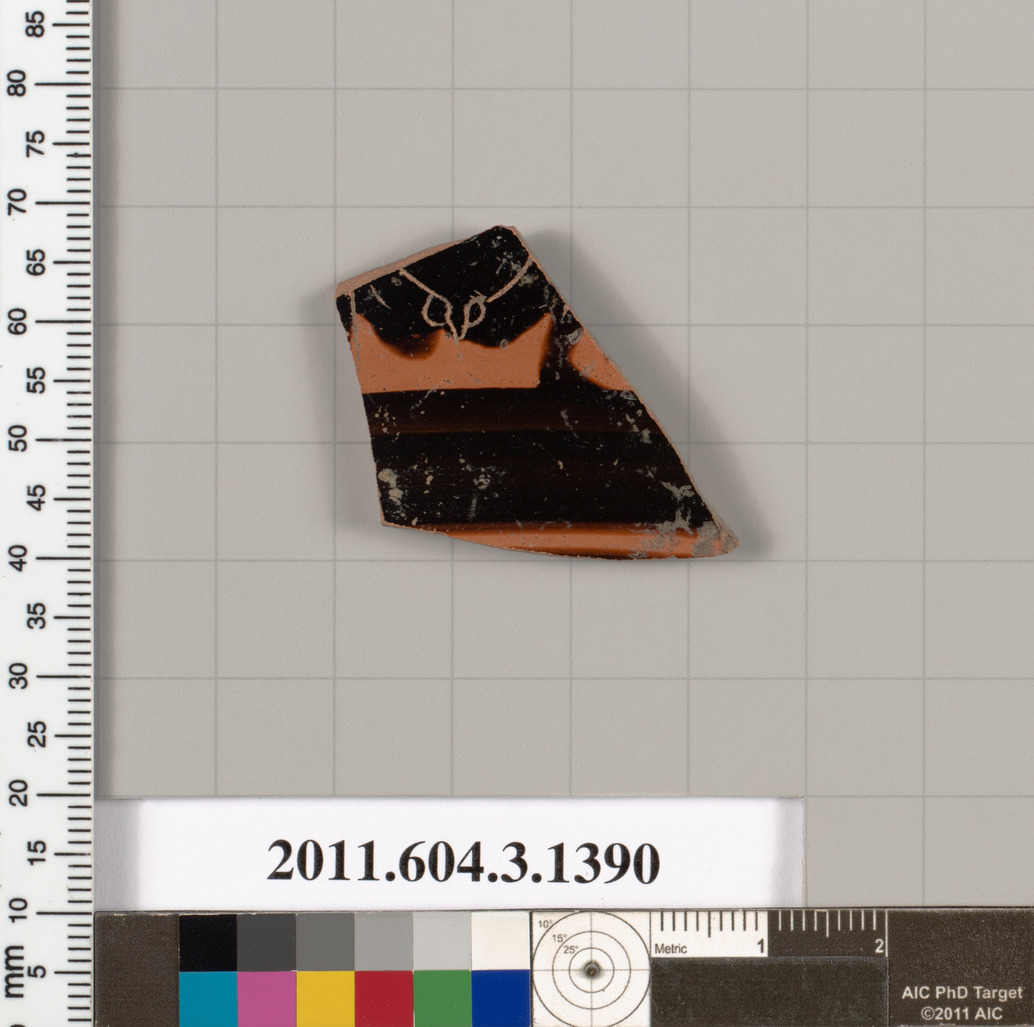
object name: skyphos fragment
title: Terracotta fragment of a skyphos (deep drinking cup)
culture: greek, attic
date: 534-468 BCE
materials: terracotta